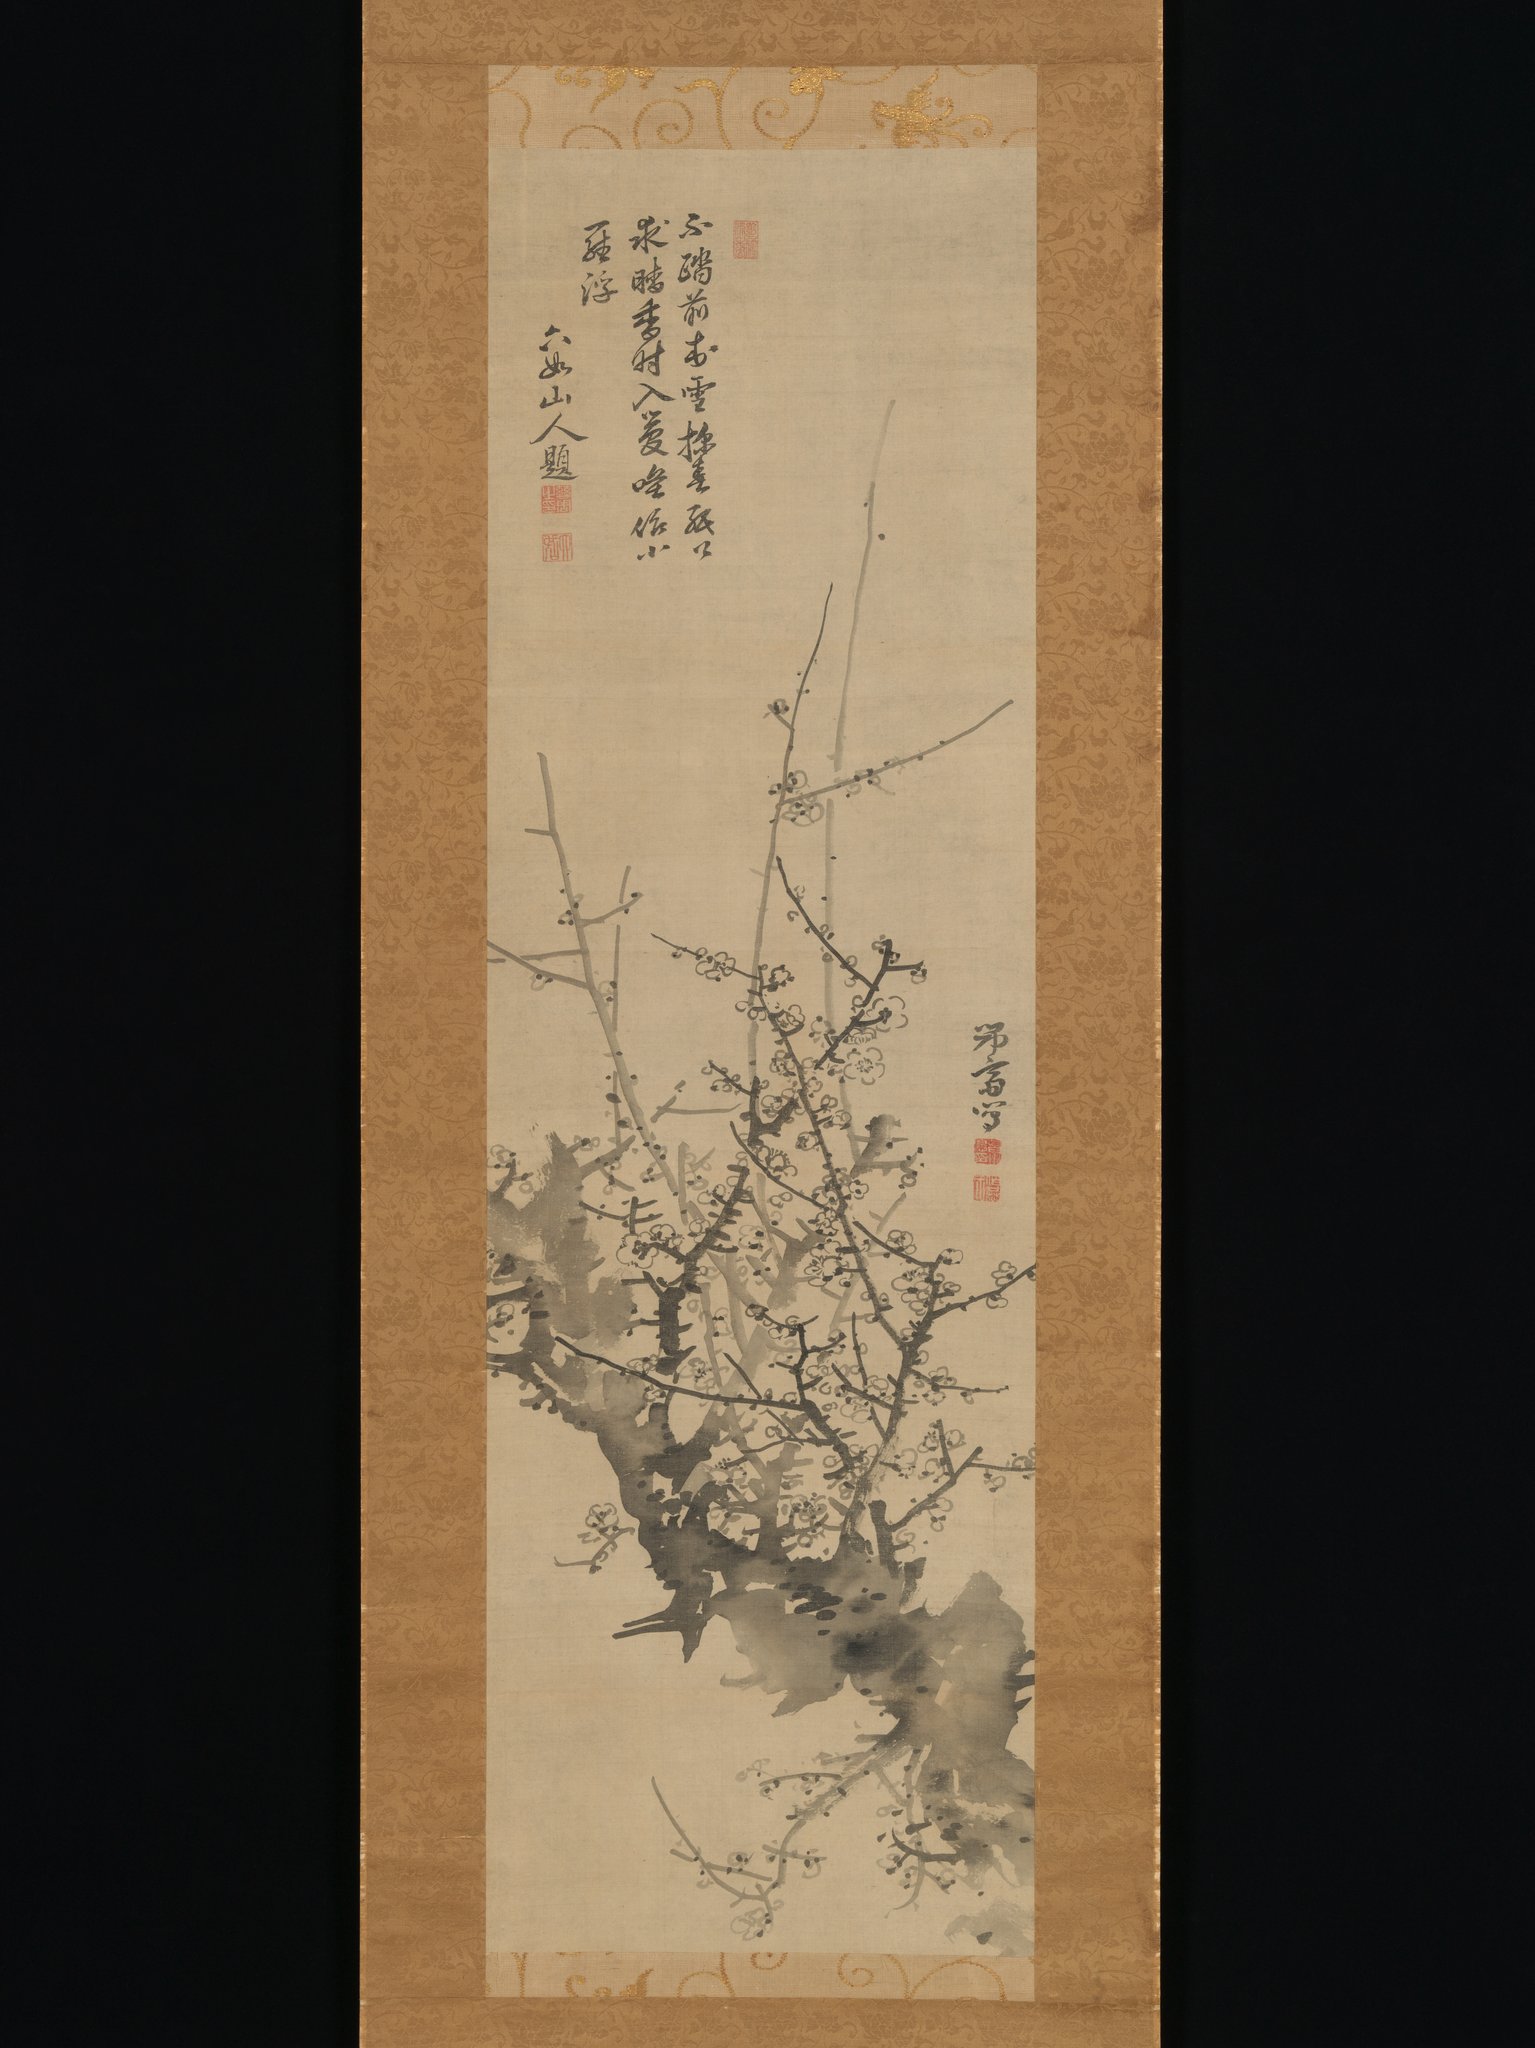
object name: hanging scroll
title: Plum Blossoms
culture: japanese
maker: minagawa kien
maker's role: artist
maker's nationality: japanese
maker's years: 1734-1807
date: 1701-1900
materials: ink, paper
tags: flowers,trees